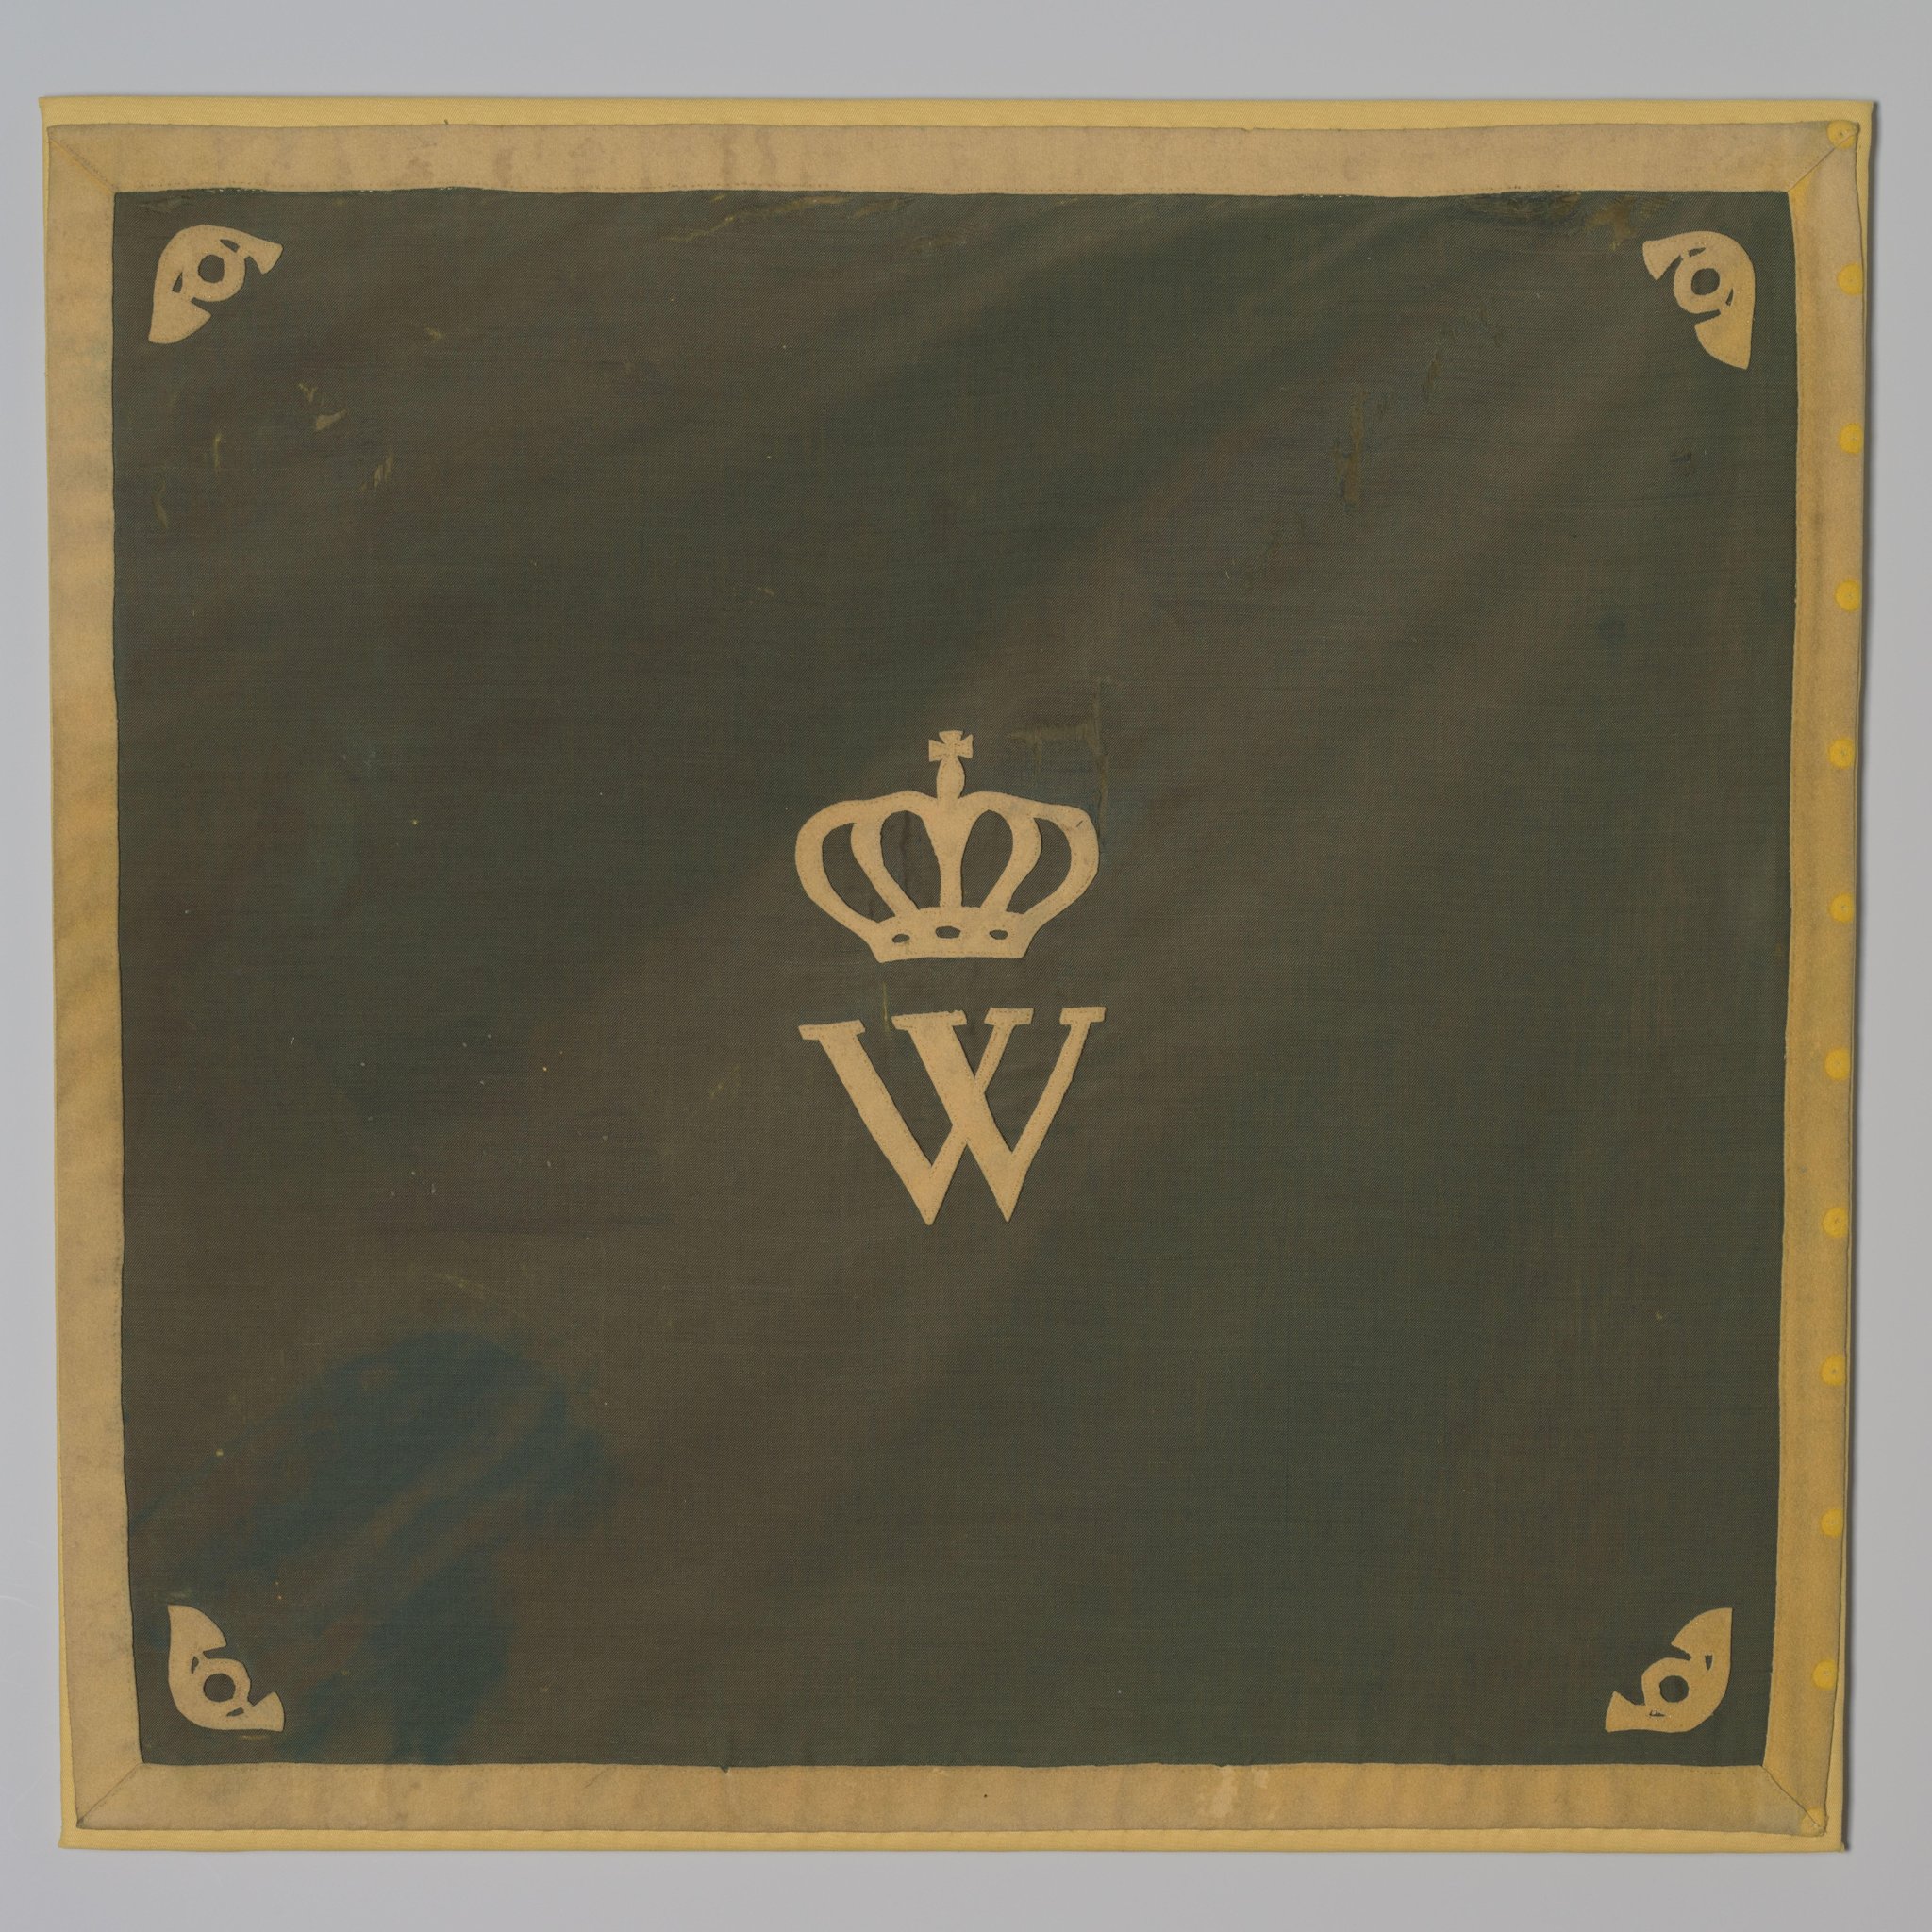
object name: richtvlag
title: Groene richtvlag met gele, gekroonde W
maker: Anonymous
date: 1831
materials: textile, cotton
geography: amsterdam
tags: the hague, berlin, william i of the netherlands, banner, standard (as symbol of the state, etc.), amsterdam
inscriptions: date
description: Groene richtvlag met gele, gekroonde W. Een groene vlag met op het midden een gele, gekroonde W, en in de hoeken een posthoorn in geel. Langs de zijden een gele zoom. Voorkant en paradekant identiek.